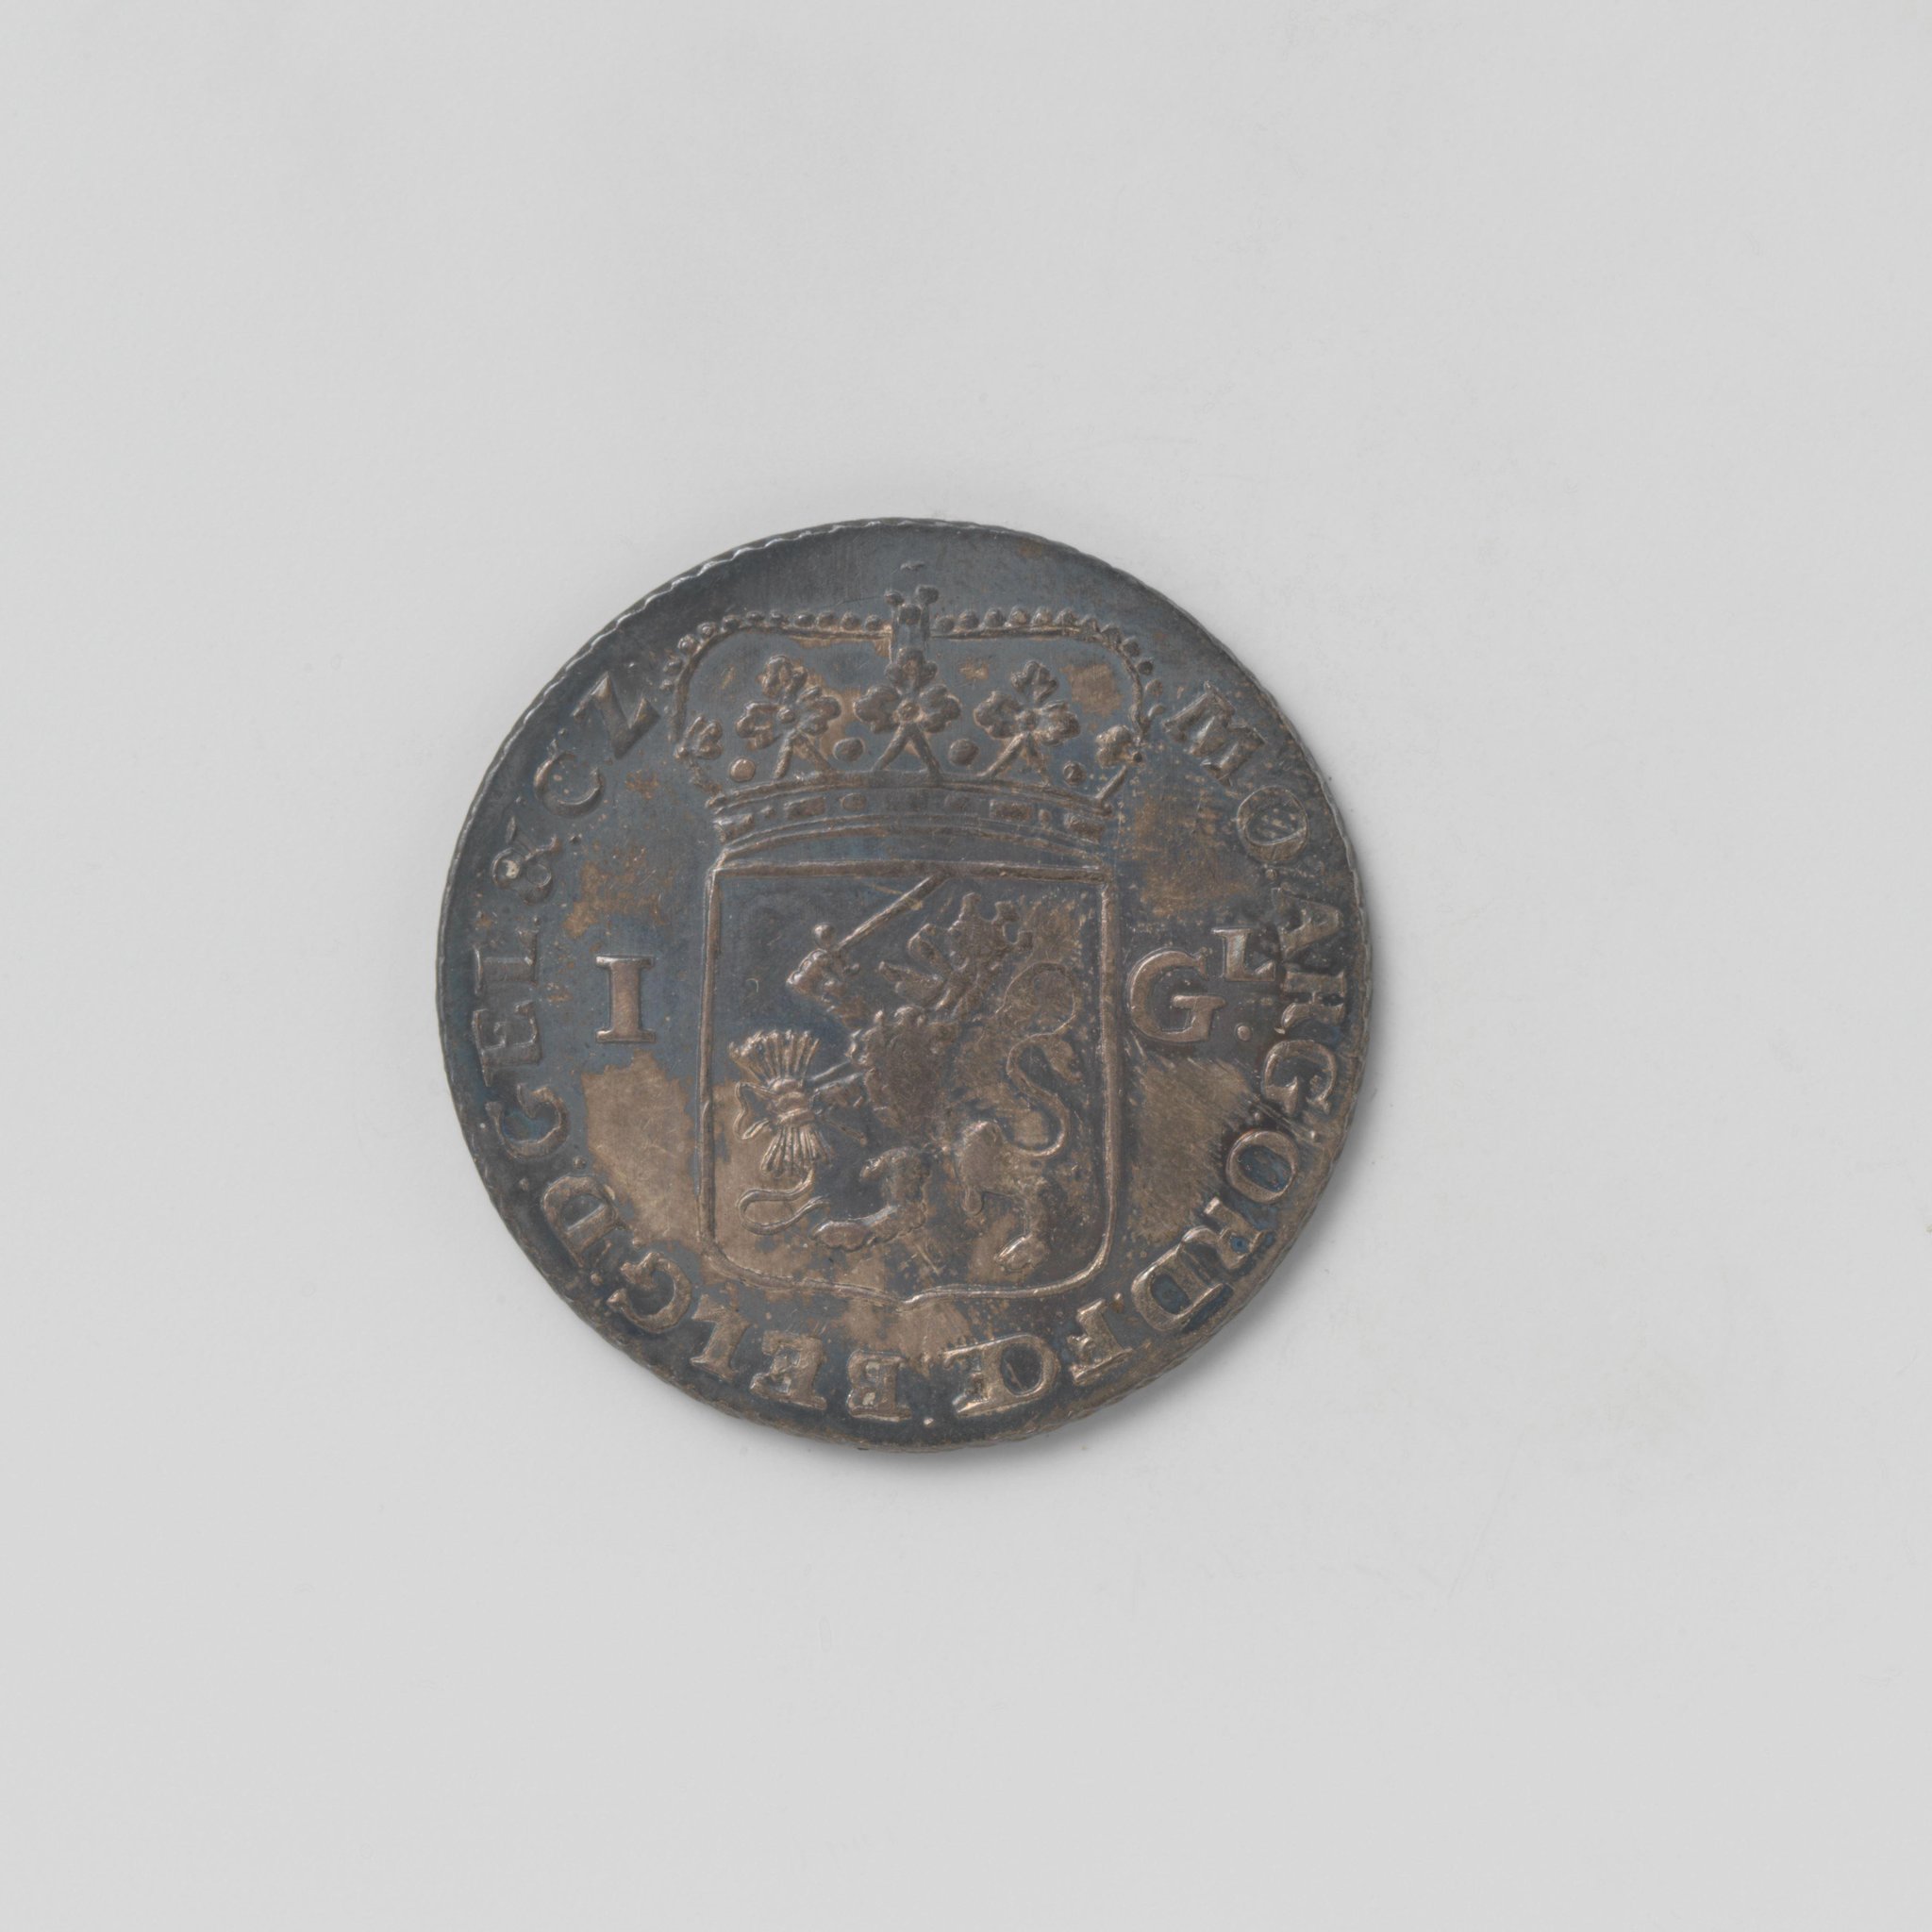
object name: coin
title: Gelderland, gulden, 1764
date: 1764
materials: silver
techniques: striking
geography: harderwijk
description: Zilveren munt. Voorzijde: tussen waarde-aanduiding gekroond generaliteitswapenschild. Keerzijde: staande Nederlandse maagd, in rechterhand lans met hoed, met linkerhand steunend op pilaar, waarop bijbel. In afsnede jaartal.